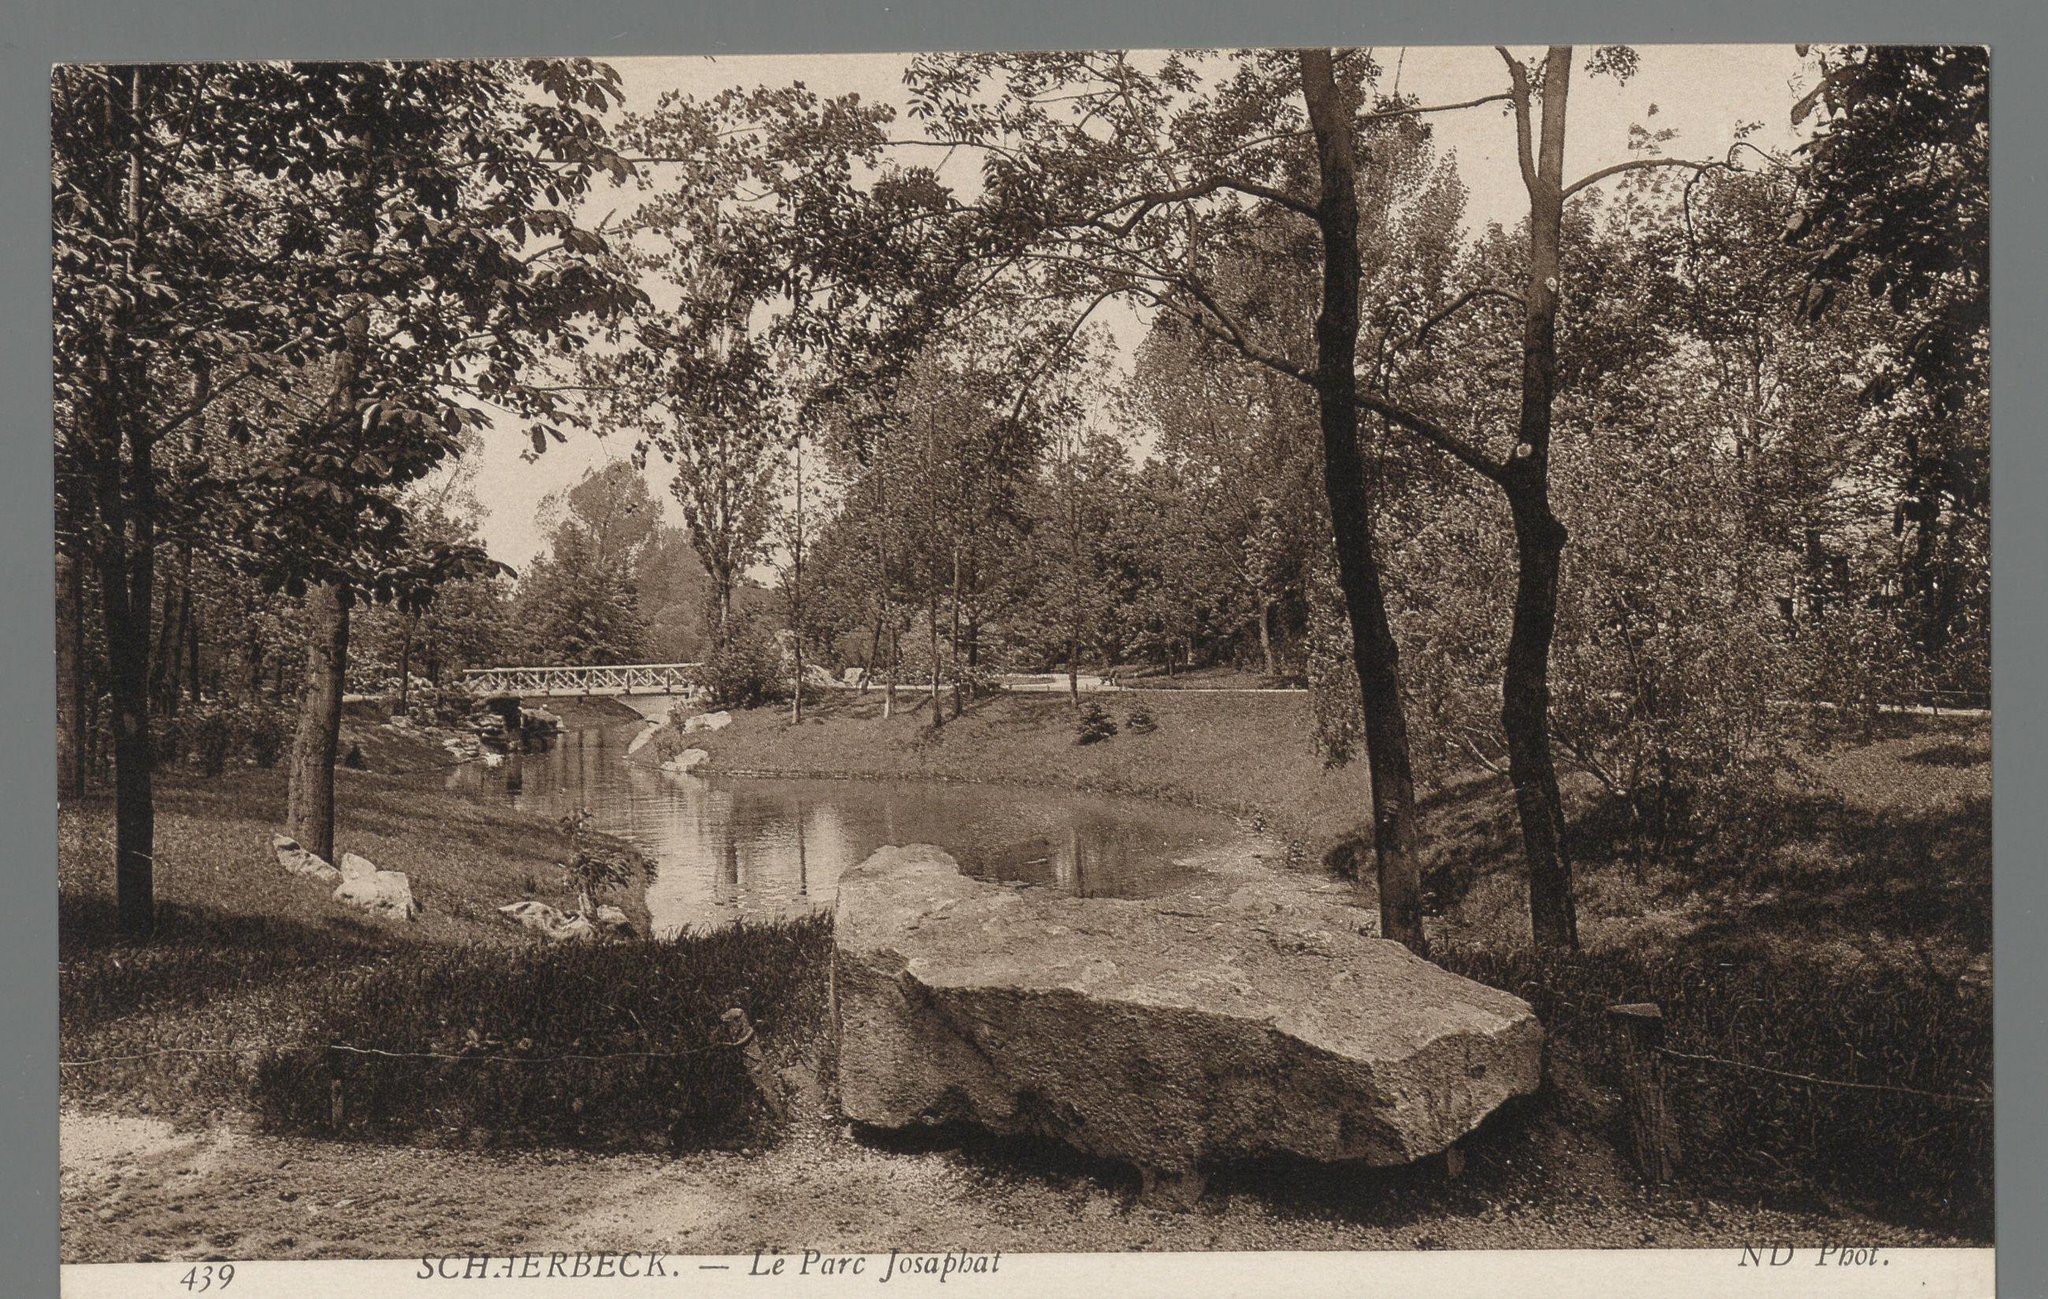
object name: photomechanical print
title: Schaerbeck. Le Parc Josaphat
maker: Anonymous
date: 1906-1918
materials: cardboard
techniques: photograph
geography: schaarbeek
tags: park, pond, pool